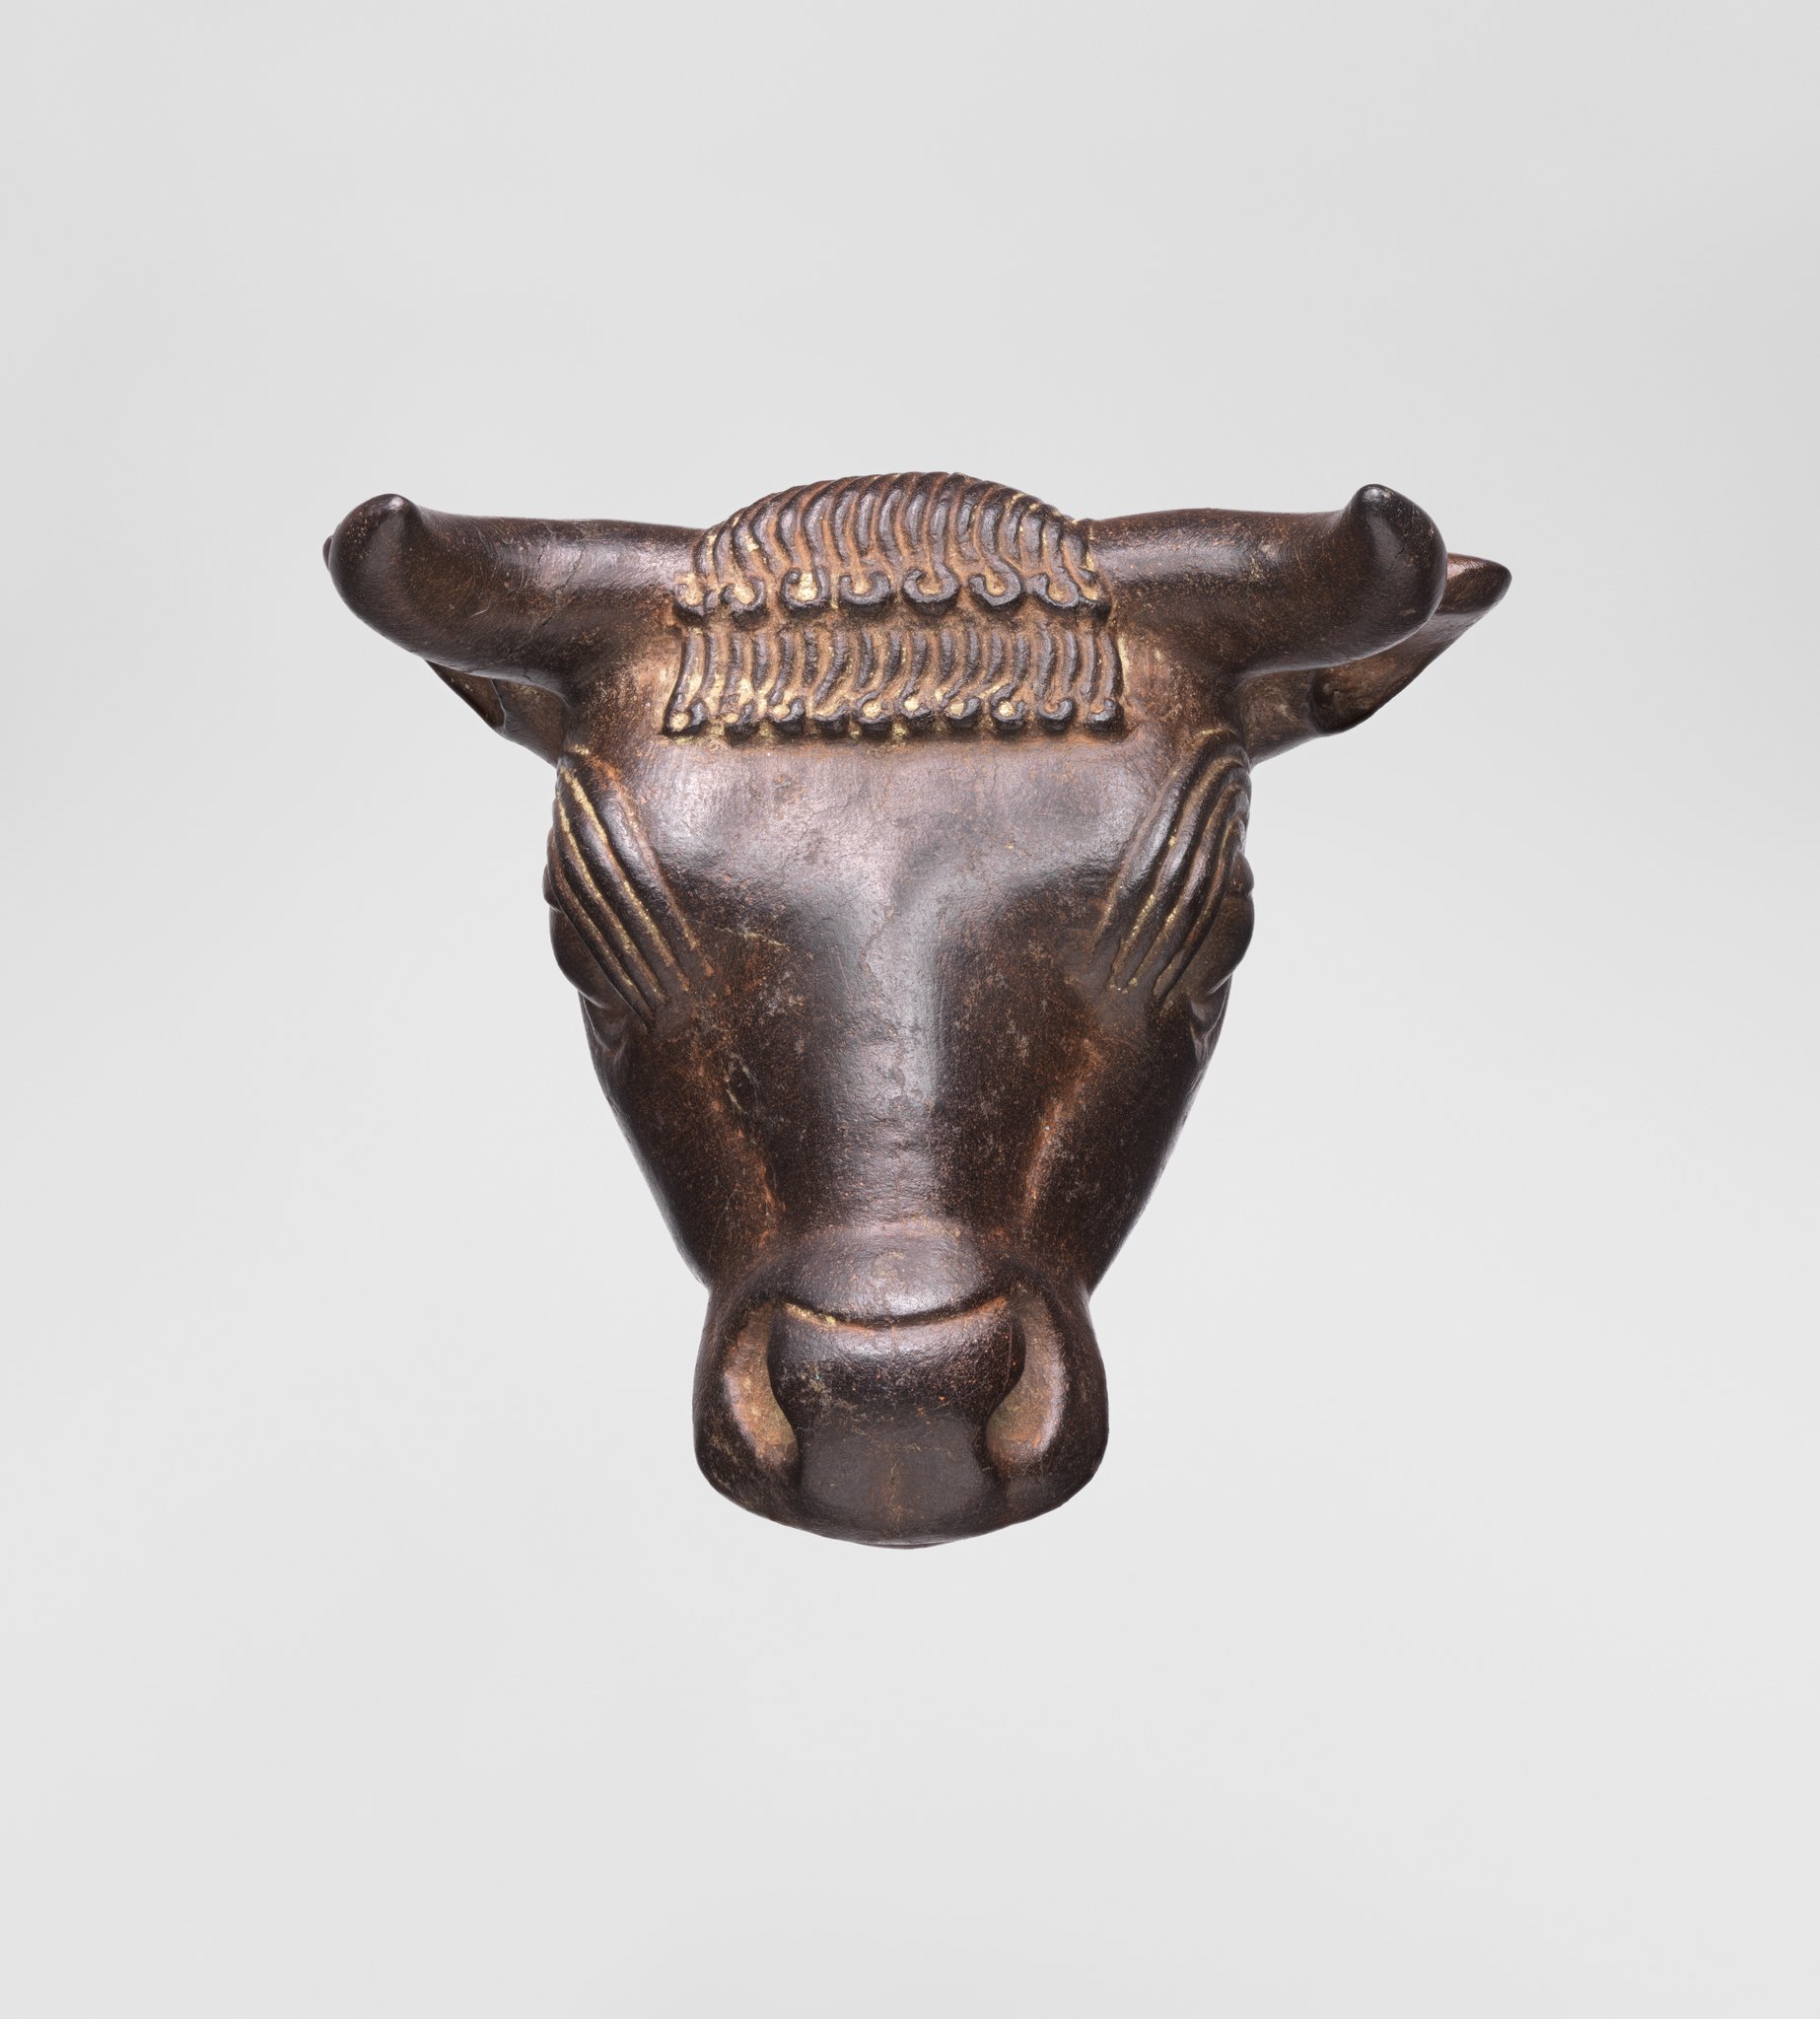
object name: sculpture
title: Bull's head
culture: neo-sumerian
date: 2100-2000 BCE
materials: stone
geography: mesopotamia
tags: bulls